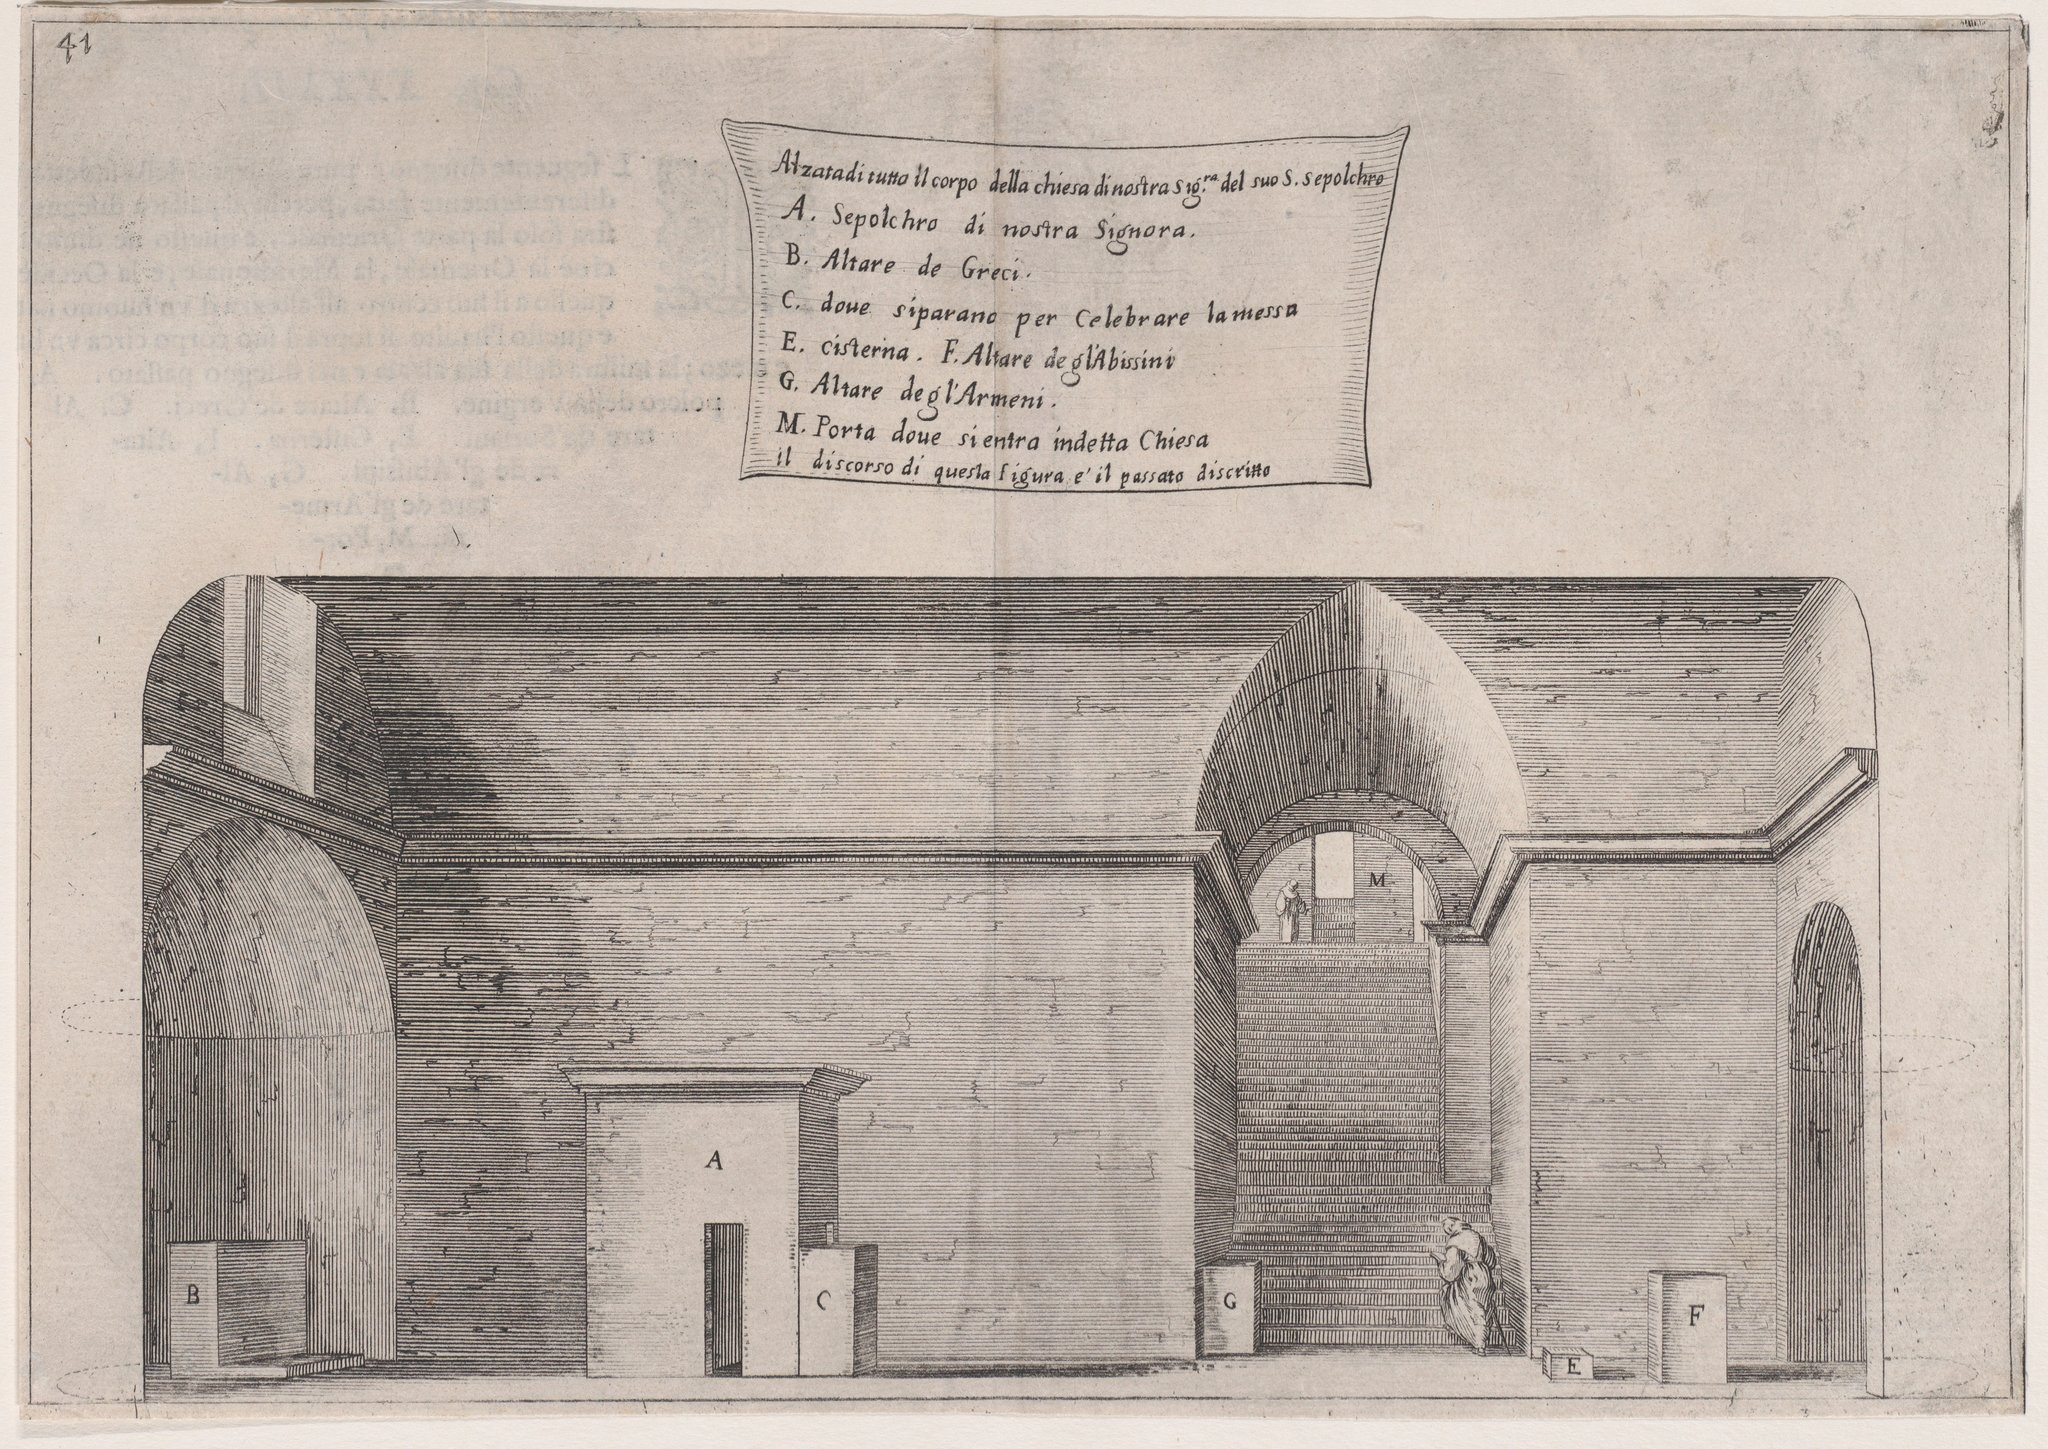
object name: print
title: Plate 34, from "Trattato delle Piante & Immagini de Sacri Edifizi di Terra Santa" (Treatise of the Plans & Images of the Sacred Buildings of the Holy Land)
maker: jacques callot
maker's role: artist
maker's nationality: french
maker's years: 1592-1635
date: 1620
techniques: engraving, etching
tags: architecture,buildings